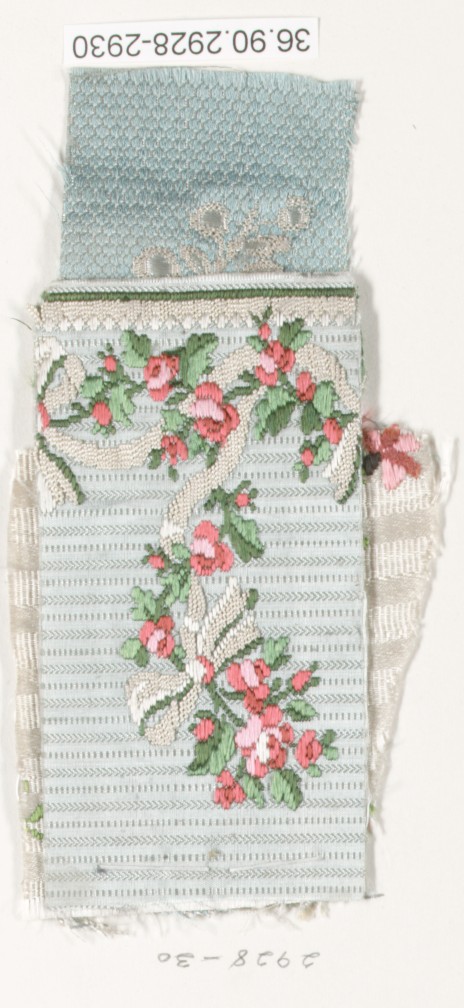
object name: piece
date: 1801-1900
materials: silk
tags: flowers,leaves